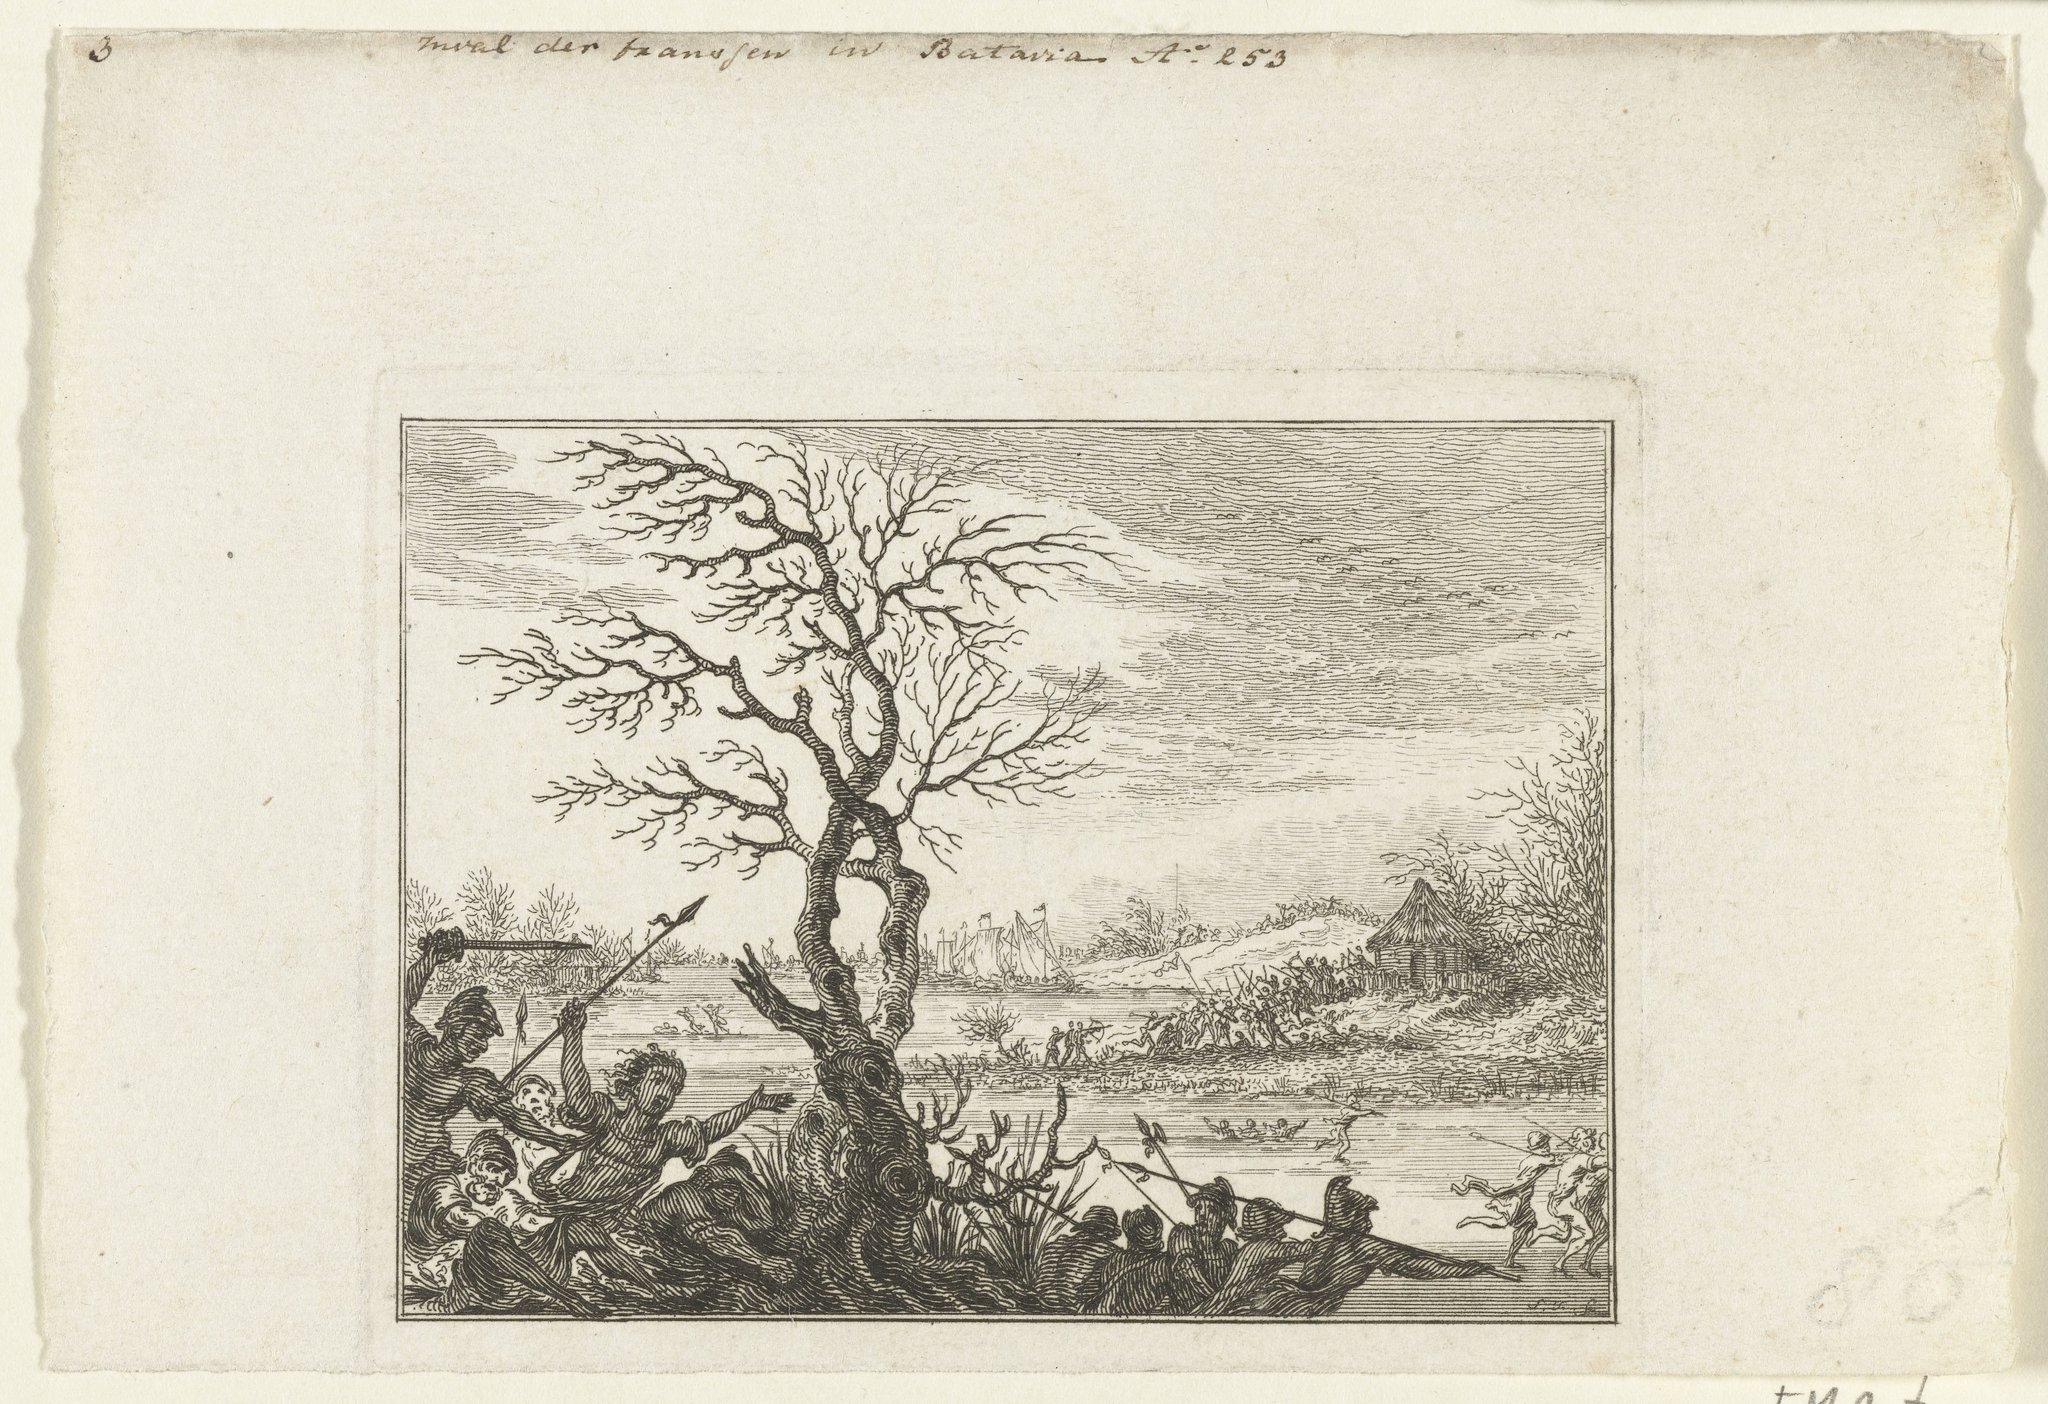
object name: print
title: De Franken vallen het land van de Bataven binnen, 253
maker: simon fokke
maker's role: draughtsman, print maker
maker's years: 1712-1784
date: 1722-1750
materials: paper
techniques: etching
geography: northern netherlands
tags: extinct, 'historical' peoples (with name), netherlands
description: Illustratie voor een onbekend werk, later hergebruikt in: J.W. te Water, De vaderlandsche Historie van den heere J. Wagenaar, verkort, en met leerzaame aanmerkingen, ten dienste der Nederlandsche jeugd, 1784-1800, 4 delen. Staat vóór de letter.